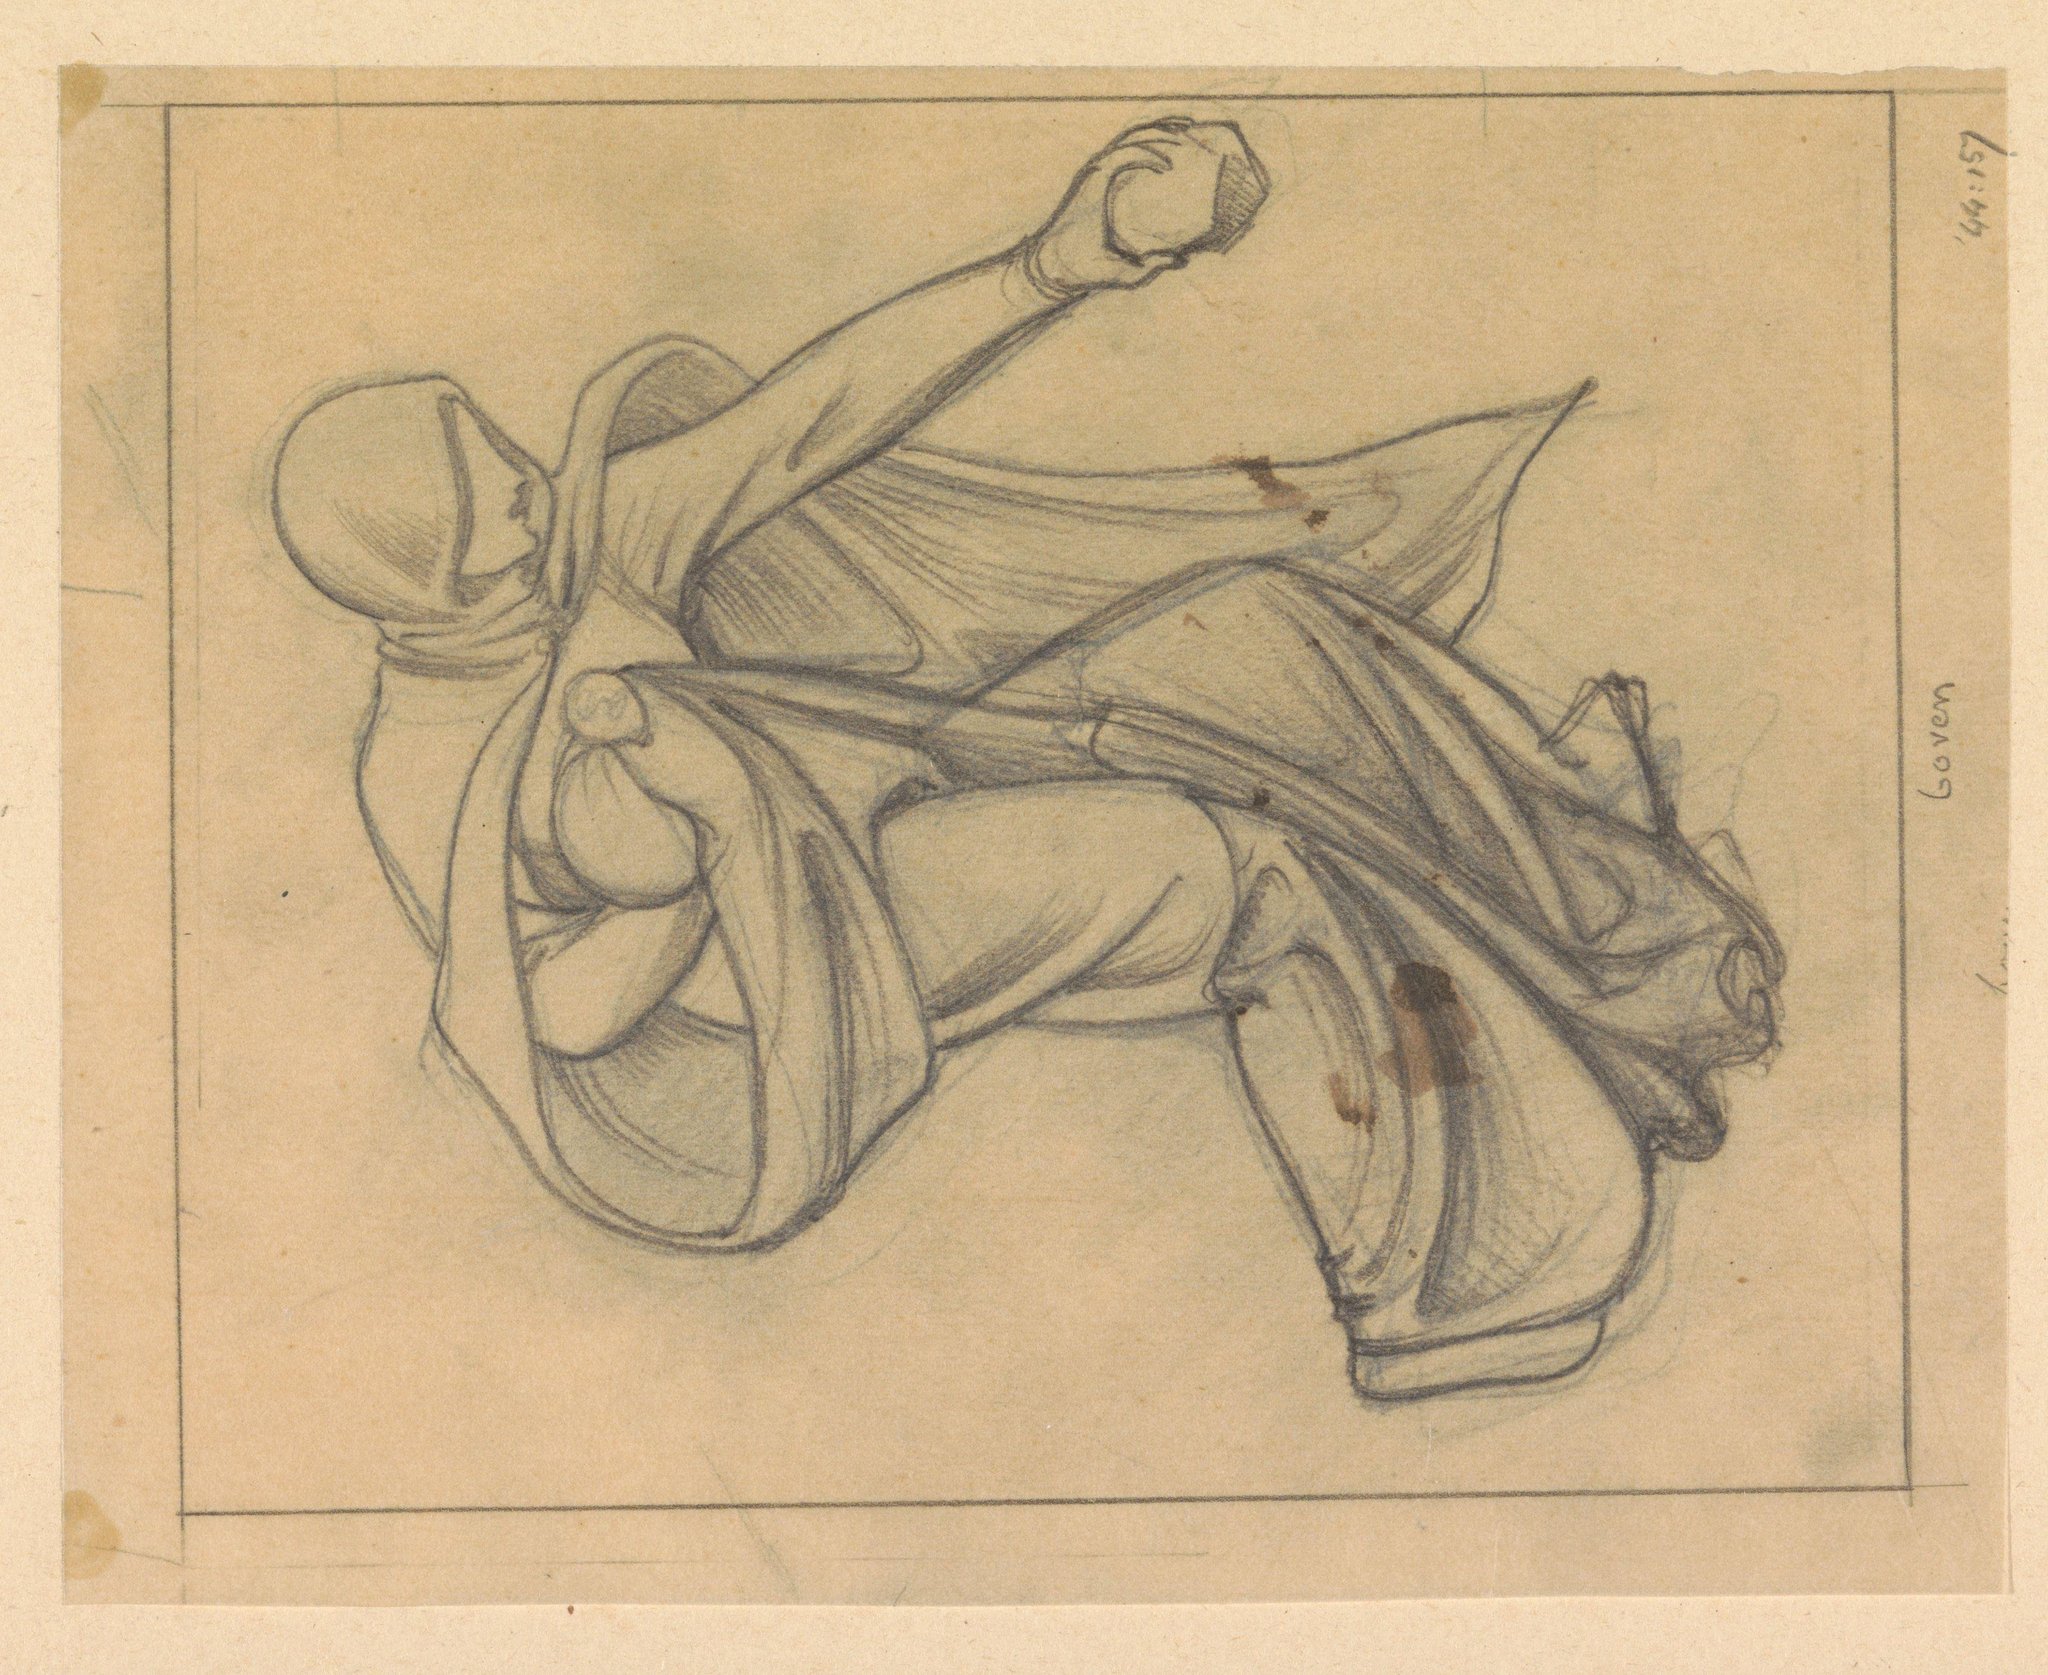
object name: design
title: Ontwerp voor wandschildering in de Beurs van Berlage: vrouw die bukt om een steen op te rapen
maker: antoon derkinderen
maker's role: draughtsman, painter, print maker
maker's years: 1859-1925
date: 1869-1925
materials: pencil, paper